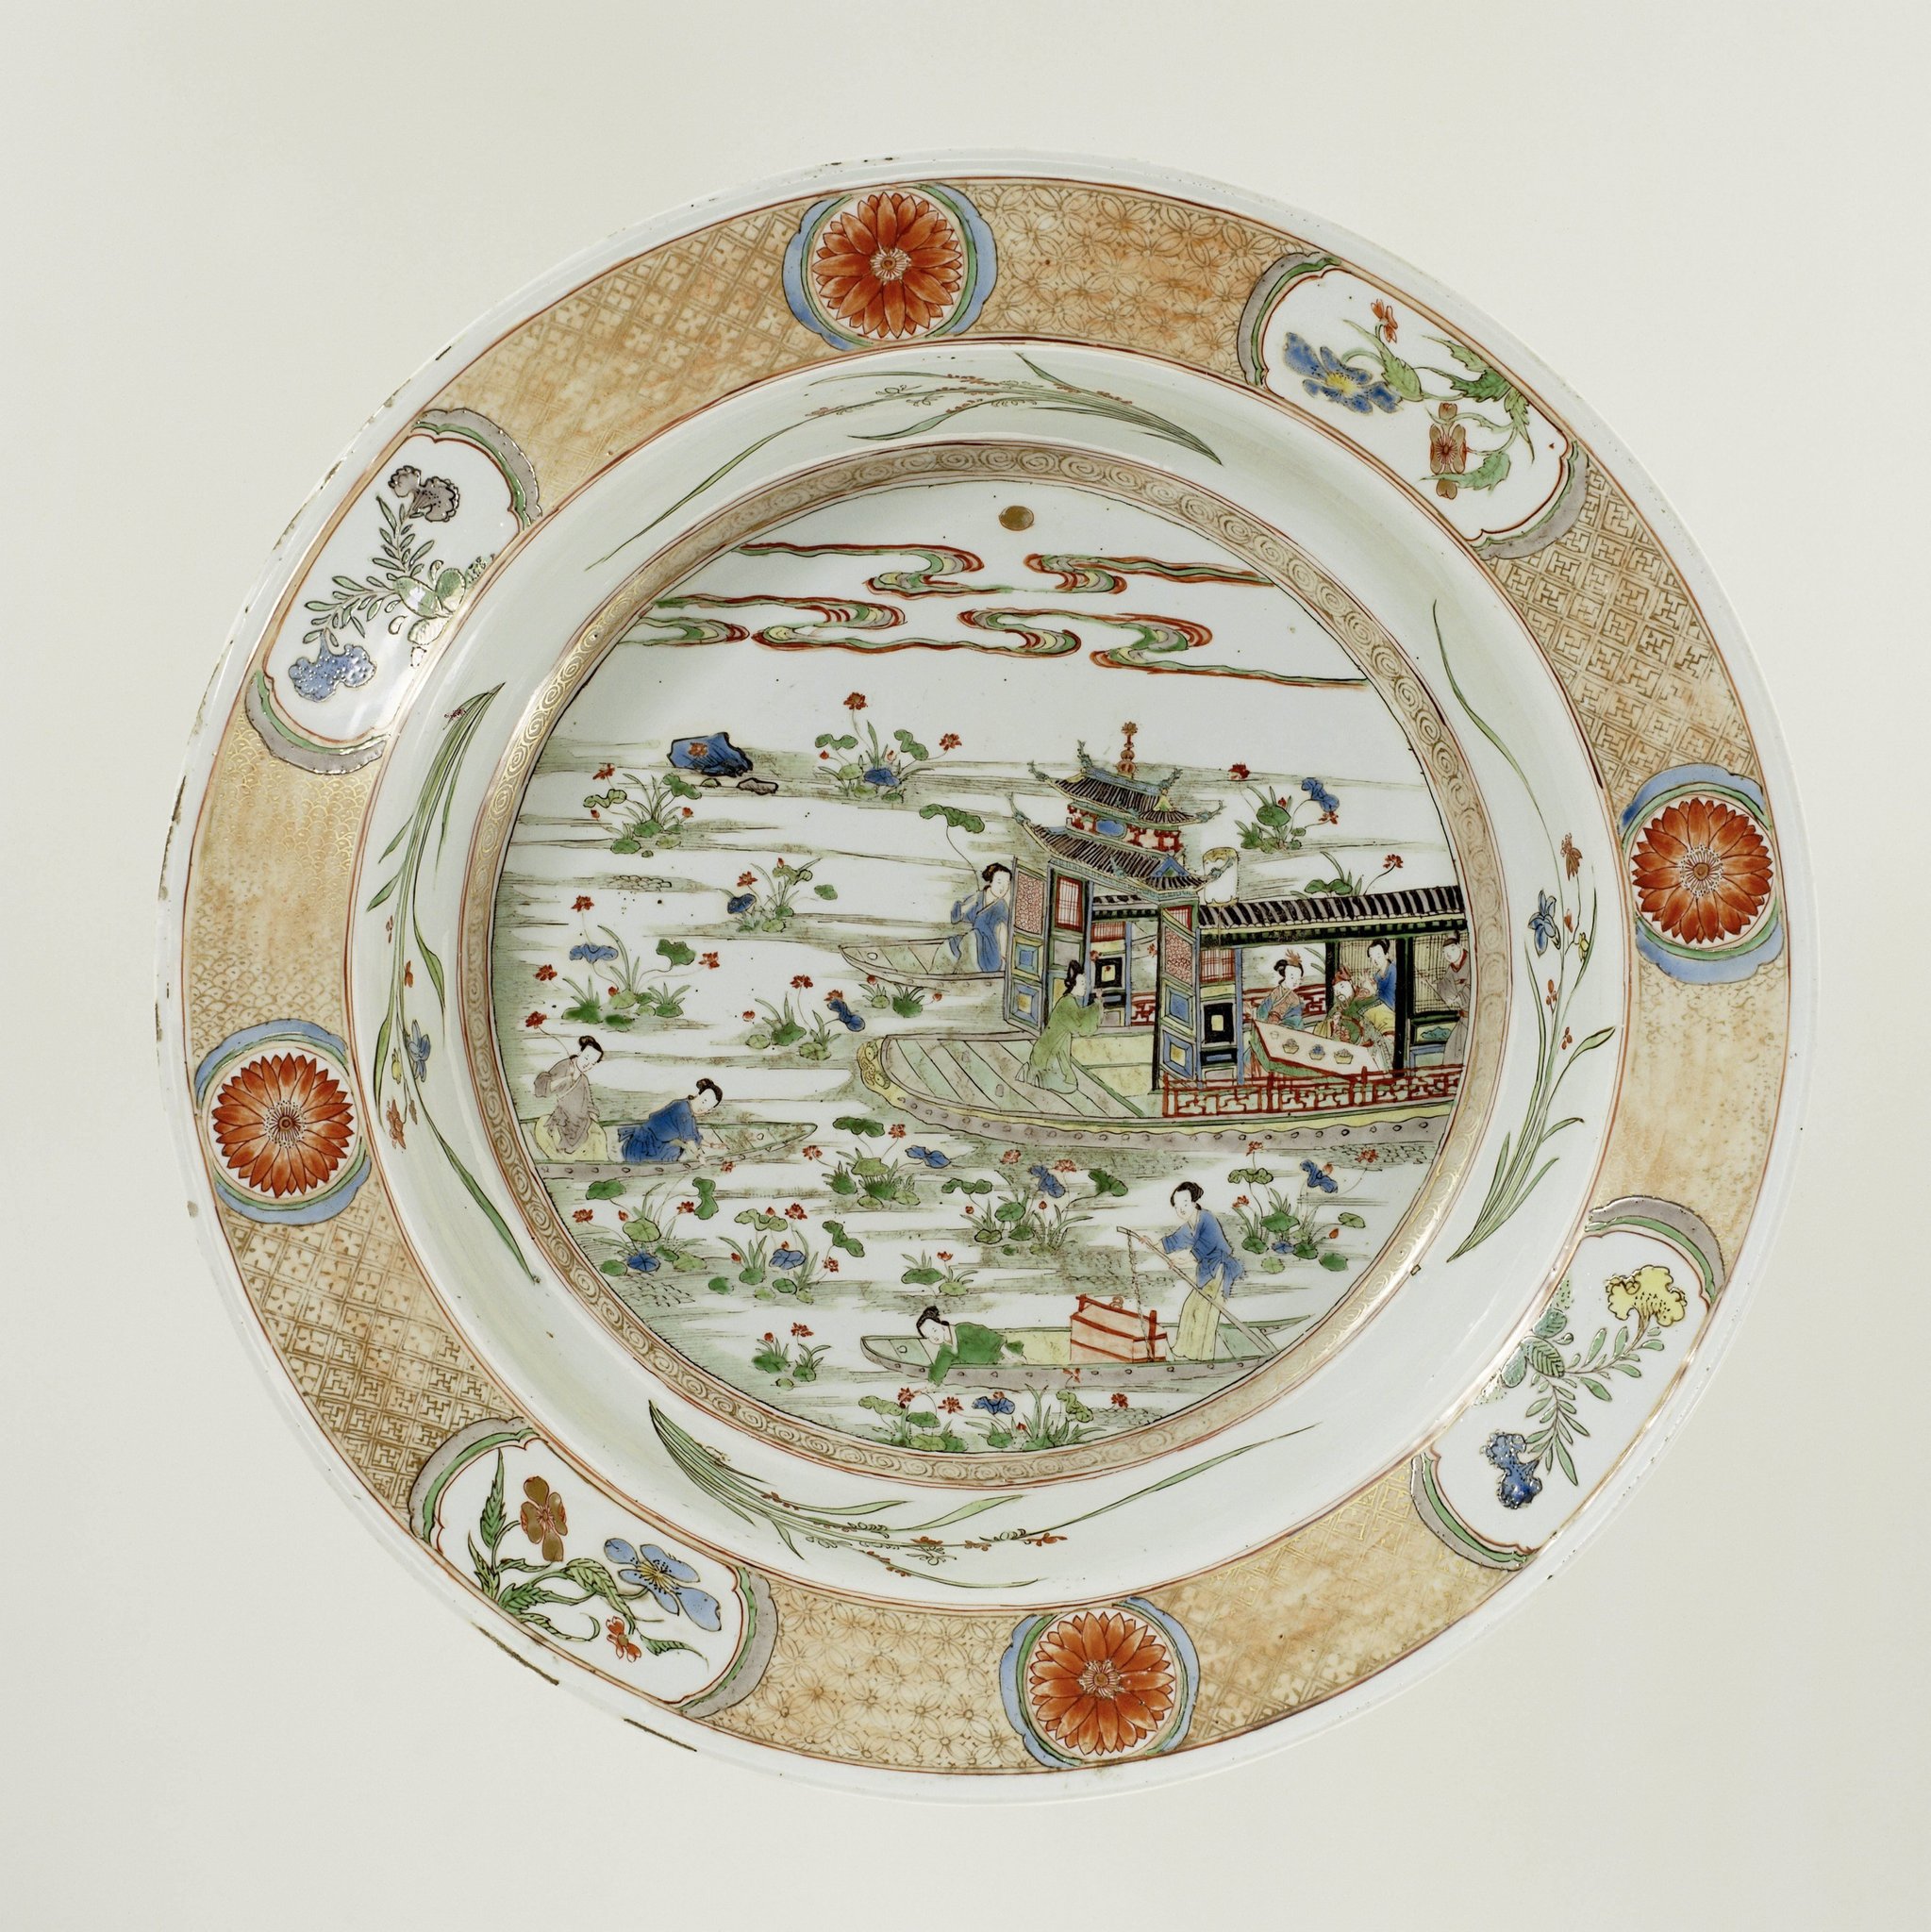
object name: platter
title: Basin with several boats on a river filled with lotus plants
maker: Anonymous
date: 1700-1724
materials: glaze, gold, paint, porcelain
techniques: firing, gilding, turning, vitrification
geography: china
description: Tang Emperor Xuanzong (r. 712-756) and his preferred concubine Lady Yang (719-756) here are enjoying a boat trip on the lake. For the favourites, life in the often harsh world of the imperial harem was like balancing on a tightrope. While they enjoyed certain liberties and exerted some influence, the envy of the official wife, the other concubines and powerful men posed a constant threat.